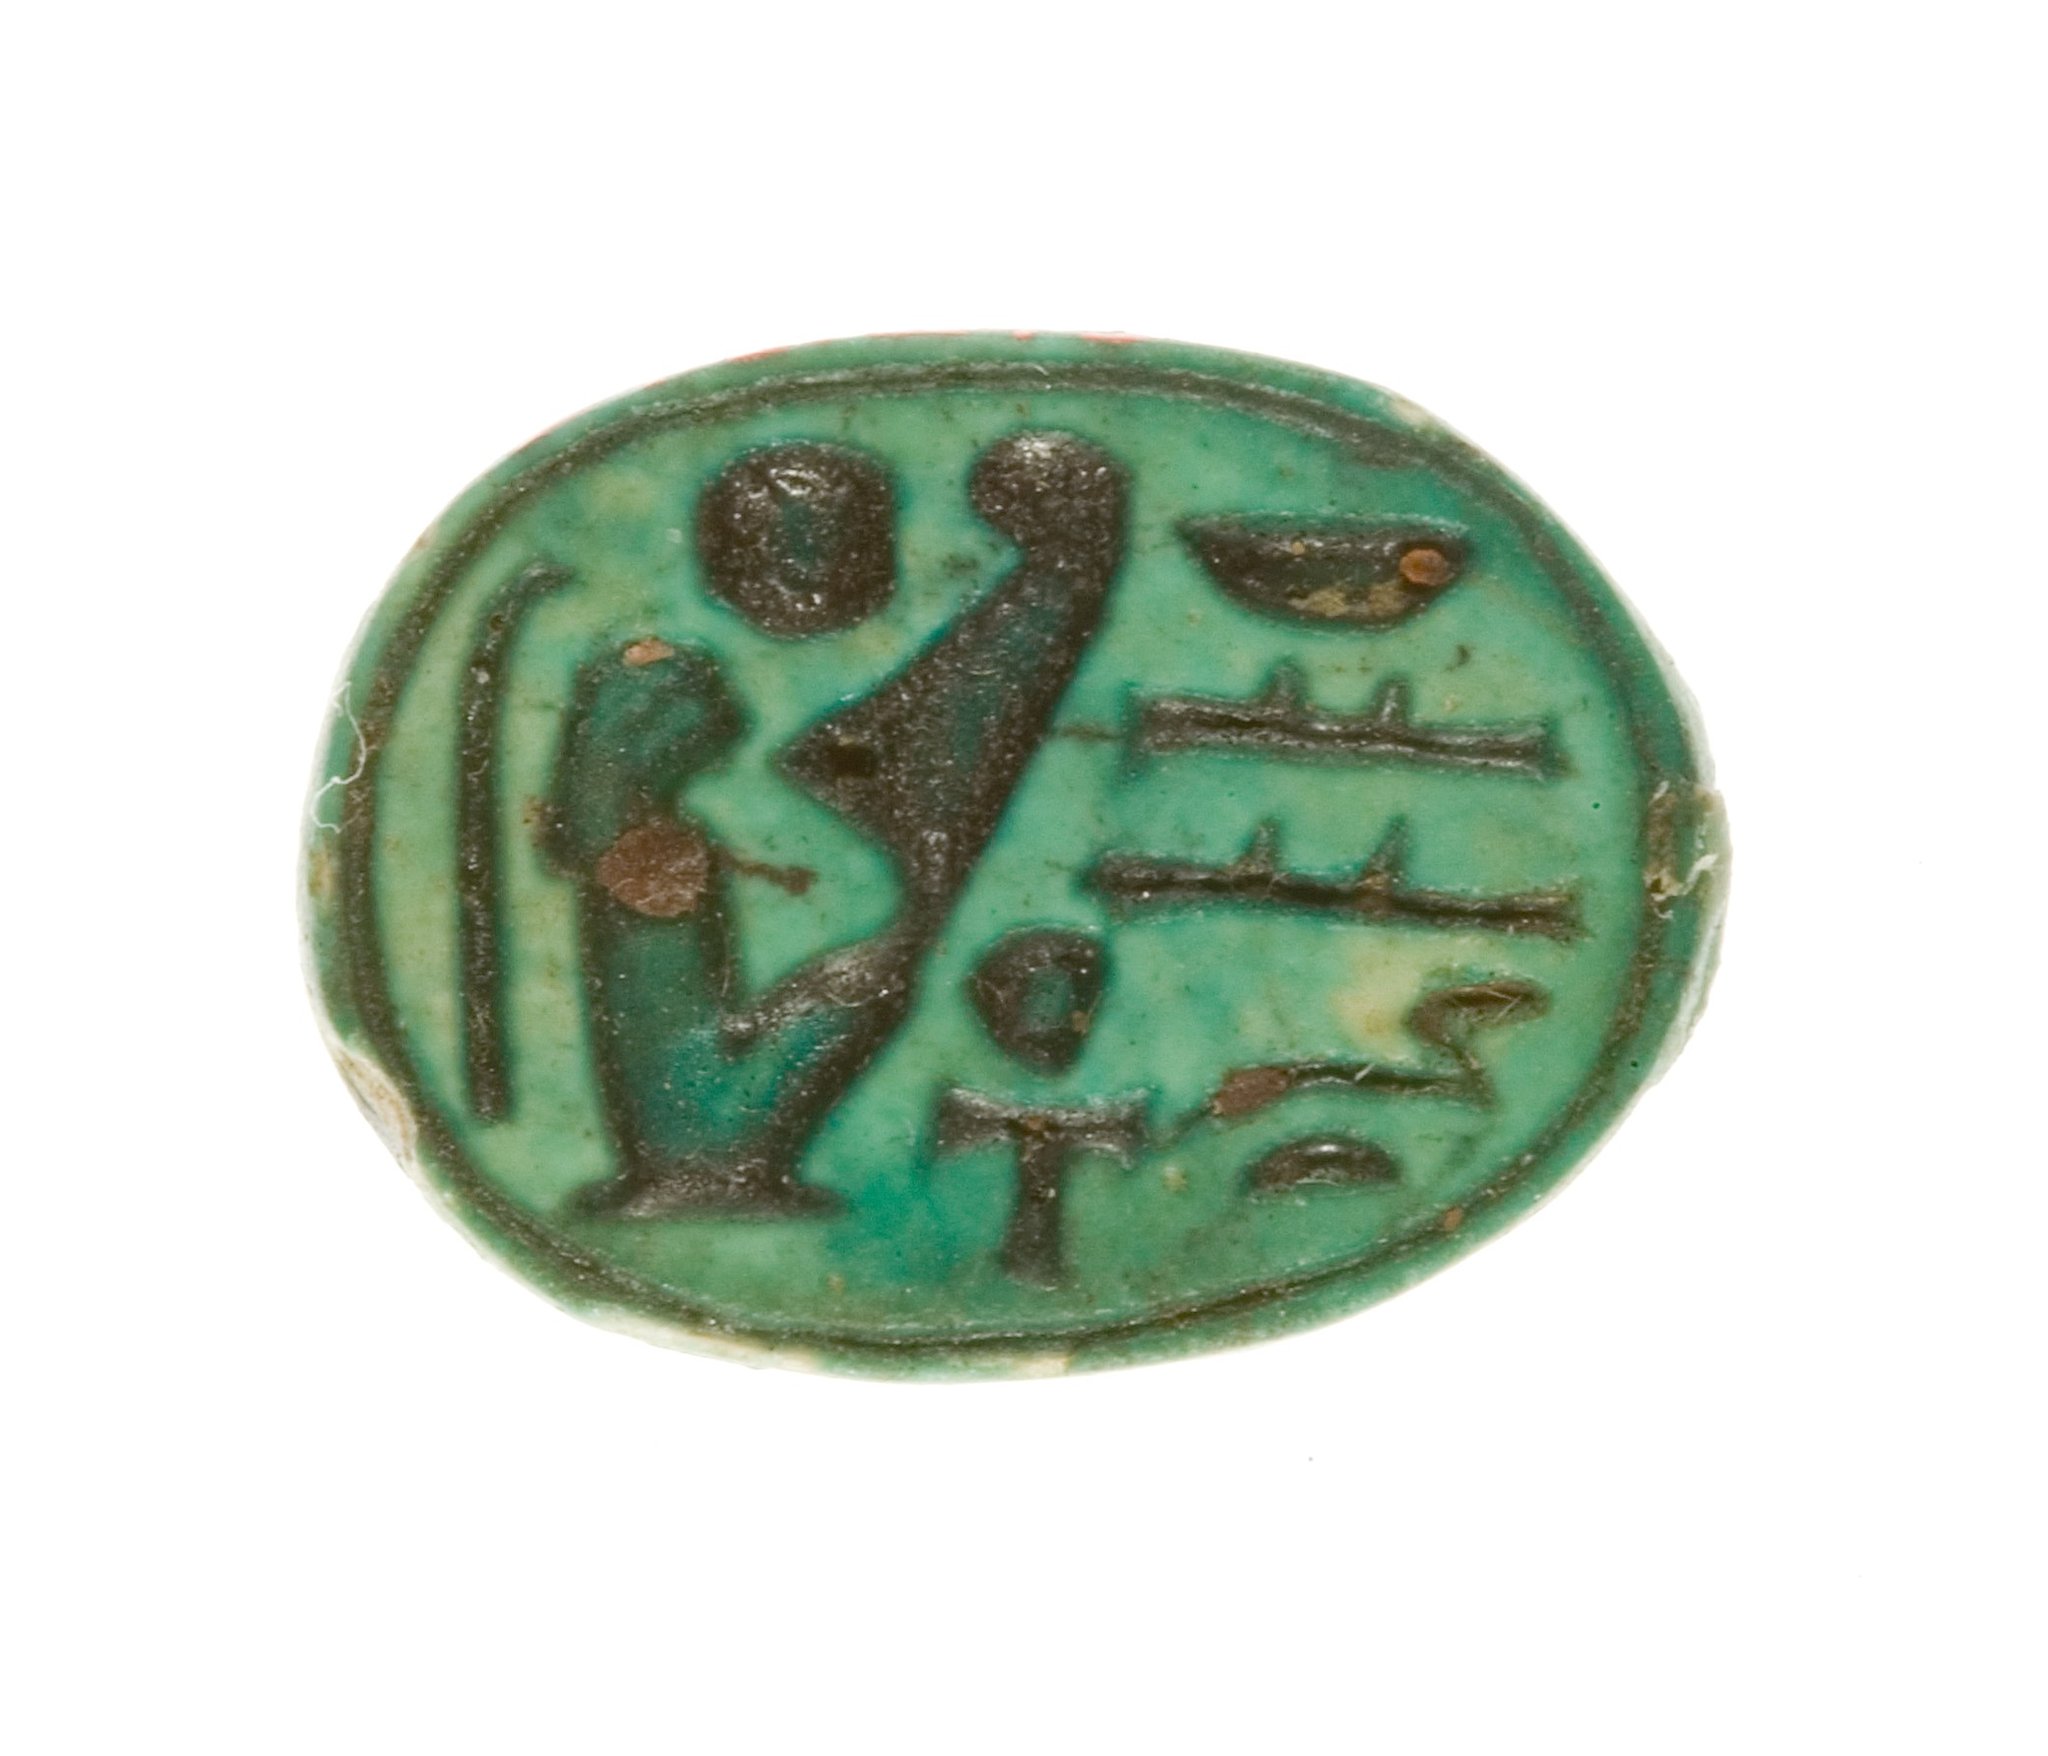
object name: scarab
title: Scarab Inscribed Lord of the Two Lands Maatkare (Hatshepsut), Living Forever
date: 1479-1458 BCE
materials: stone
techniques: glazing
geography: egypt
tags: hieroglyphs,scarabs